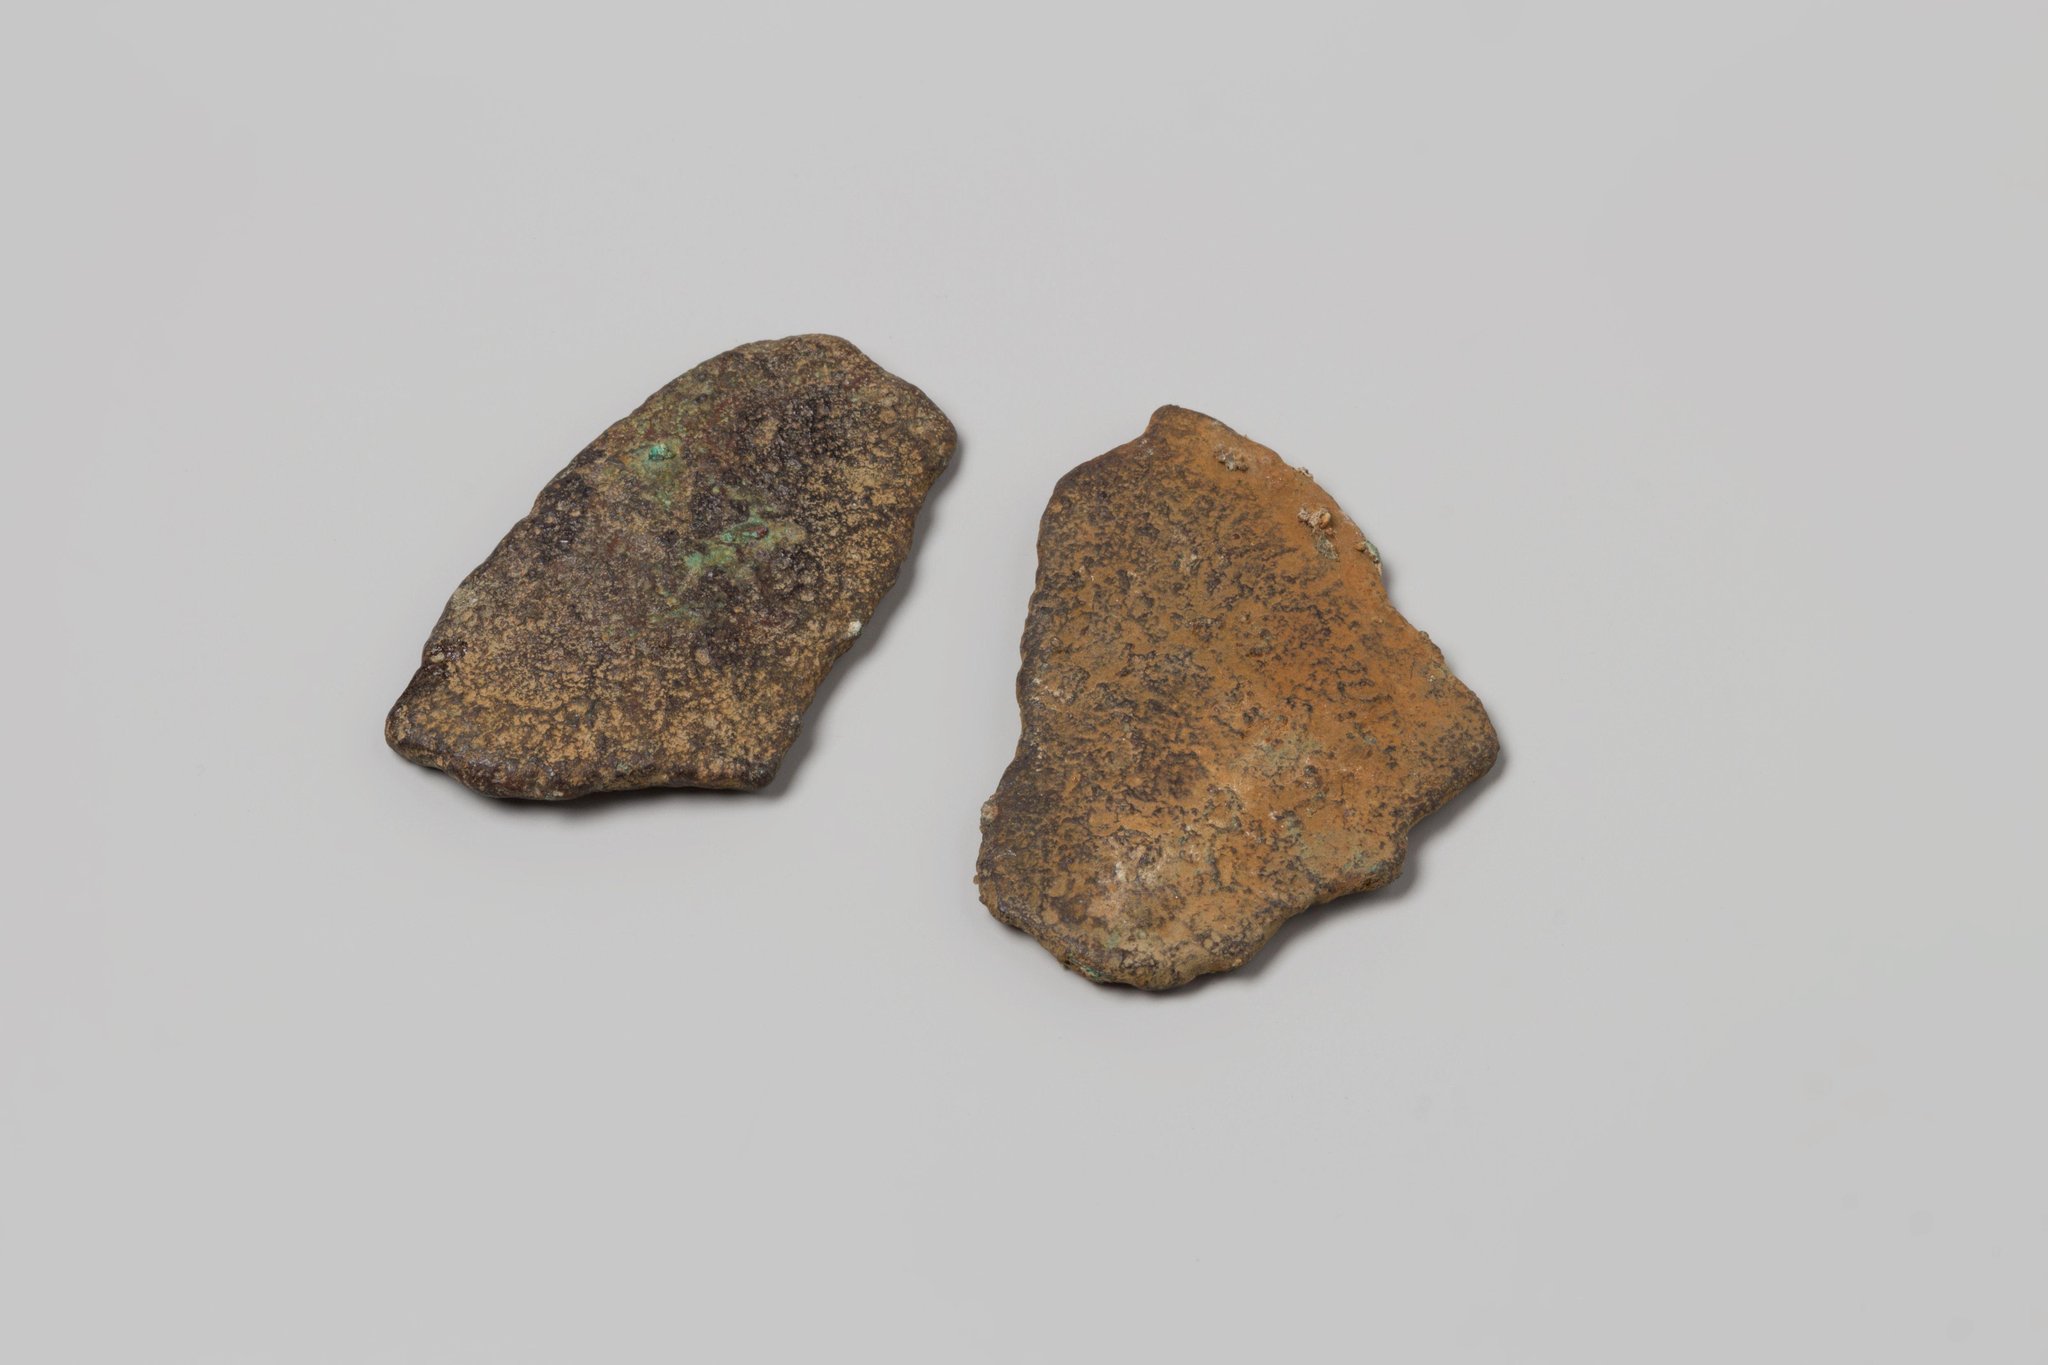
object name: fragment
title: Fragmenten koper uit het wrak van de Oost-Indiëvaarder Hollandia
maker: Anonymous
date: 1700-1743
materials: copper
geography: netherlands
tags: verenigde oostindische compagnie, hollandia (schip), annet